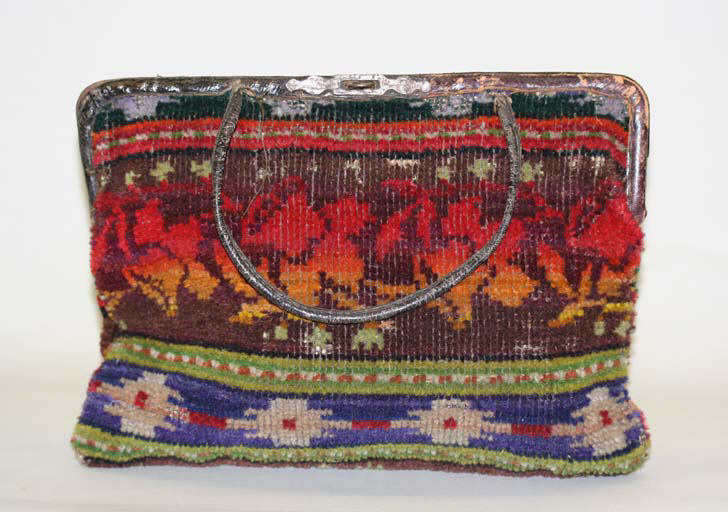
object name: purse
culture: european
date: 1801-1900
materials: leather, linen